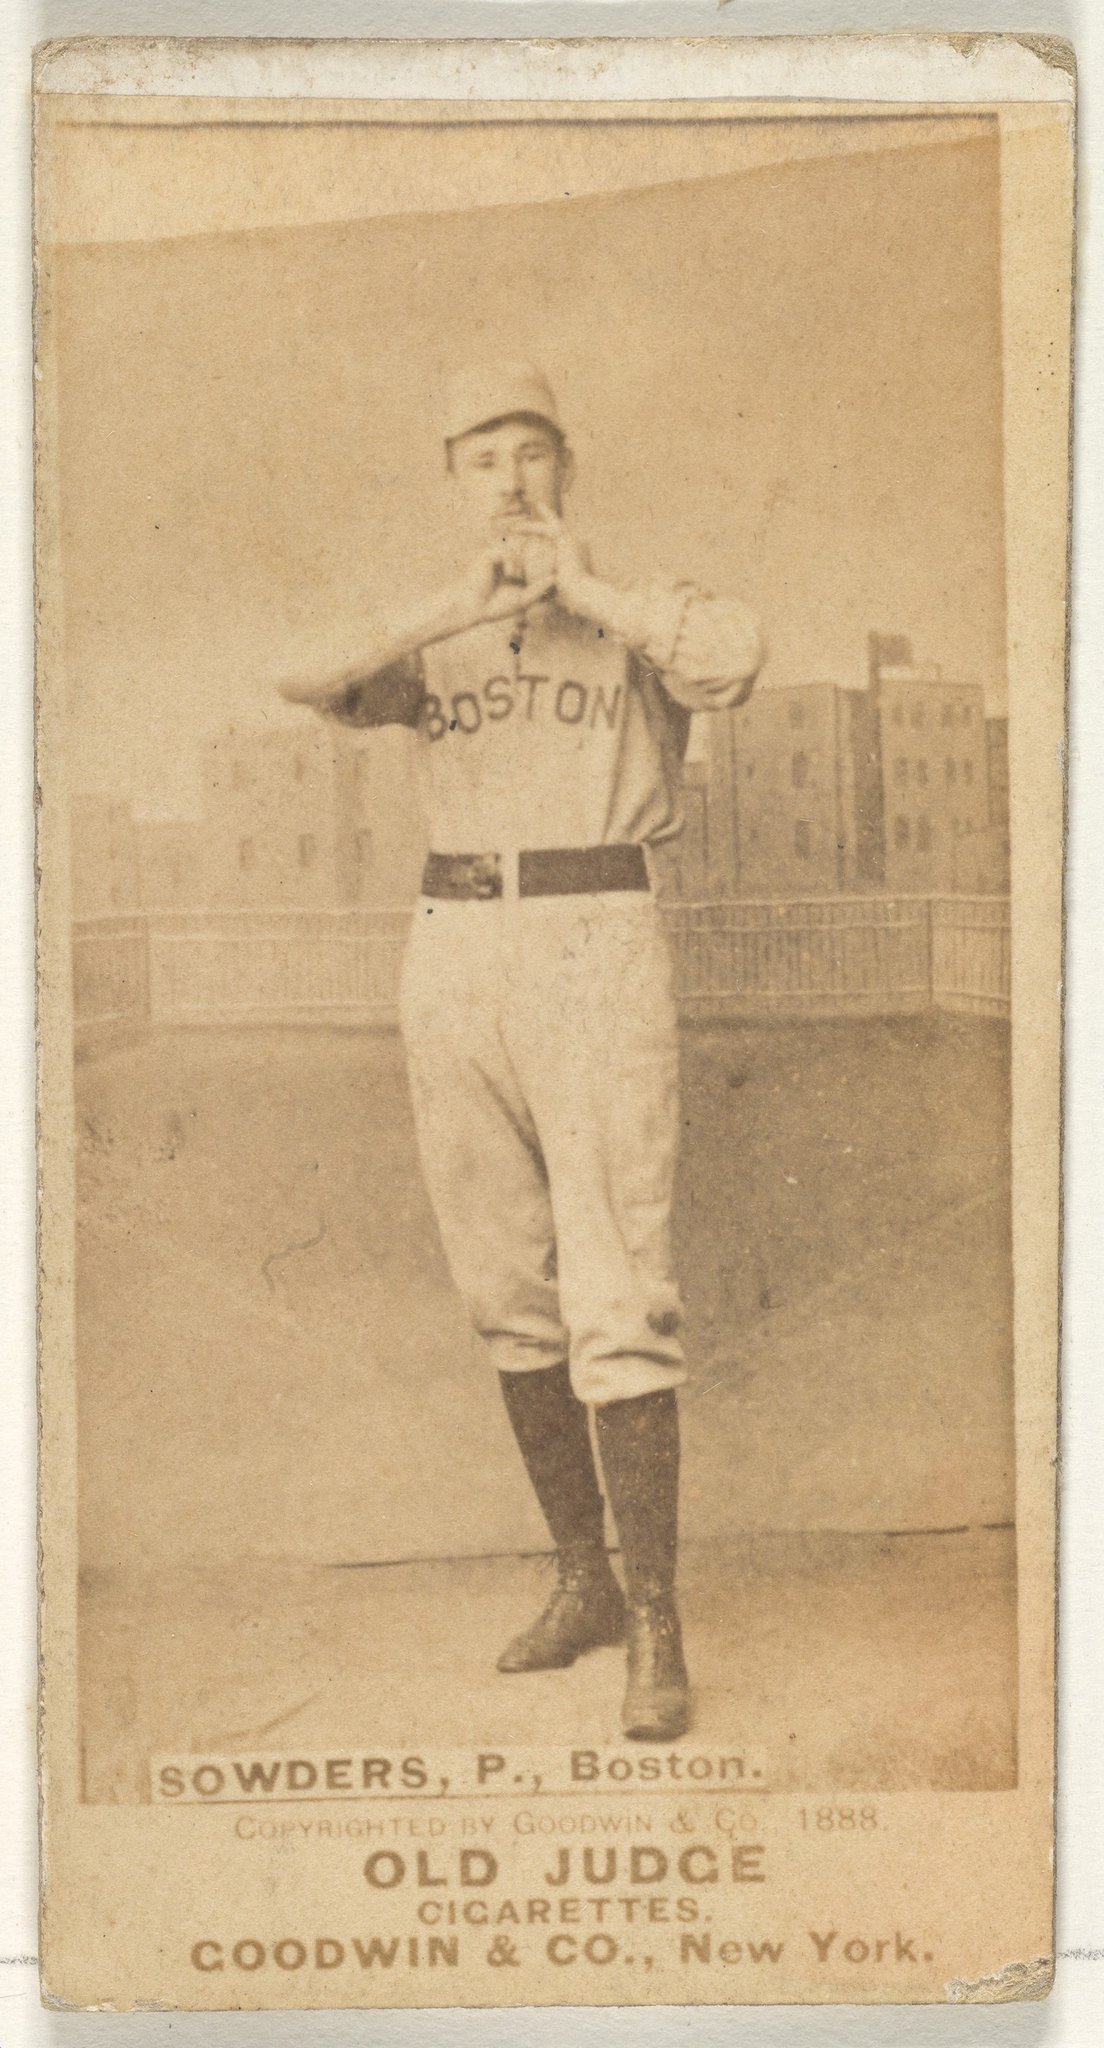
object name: baseball card, photograph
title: Sowders, Pitcher, Boston, from the Old Judge series (N172) for Old Judge Cigarettes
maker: goodwin & company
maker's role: publisher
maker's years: 1850-1950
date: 1888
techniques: albumen silver print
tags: men,portraits,baseball,athletes